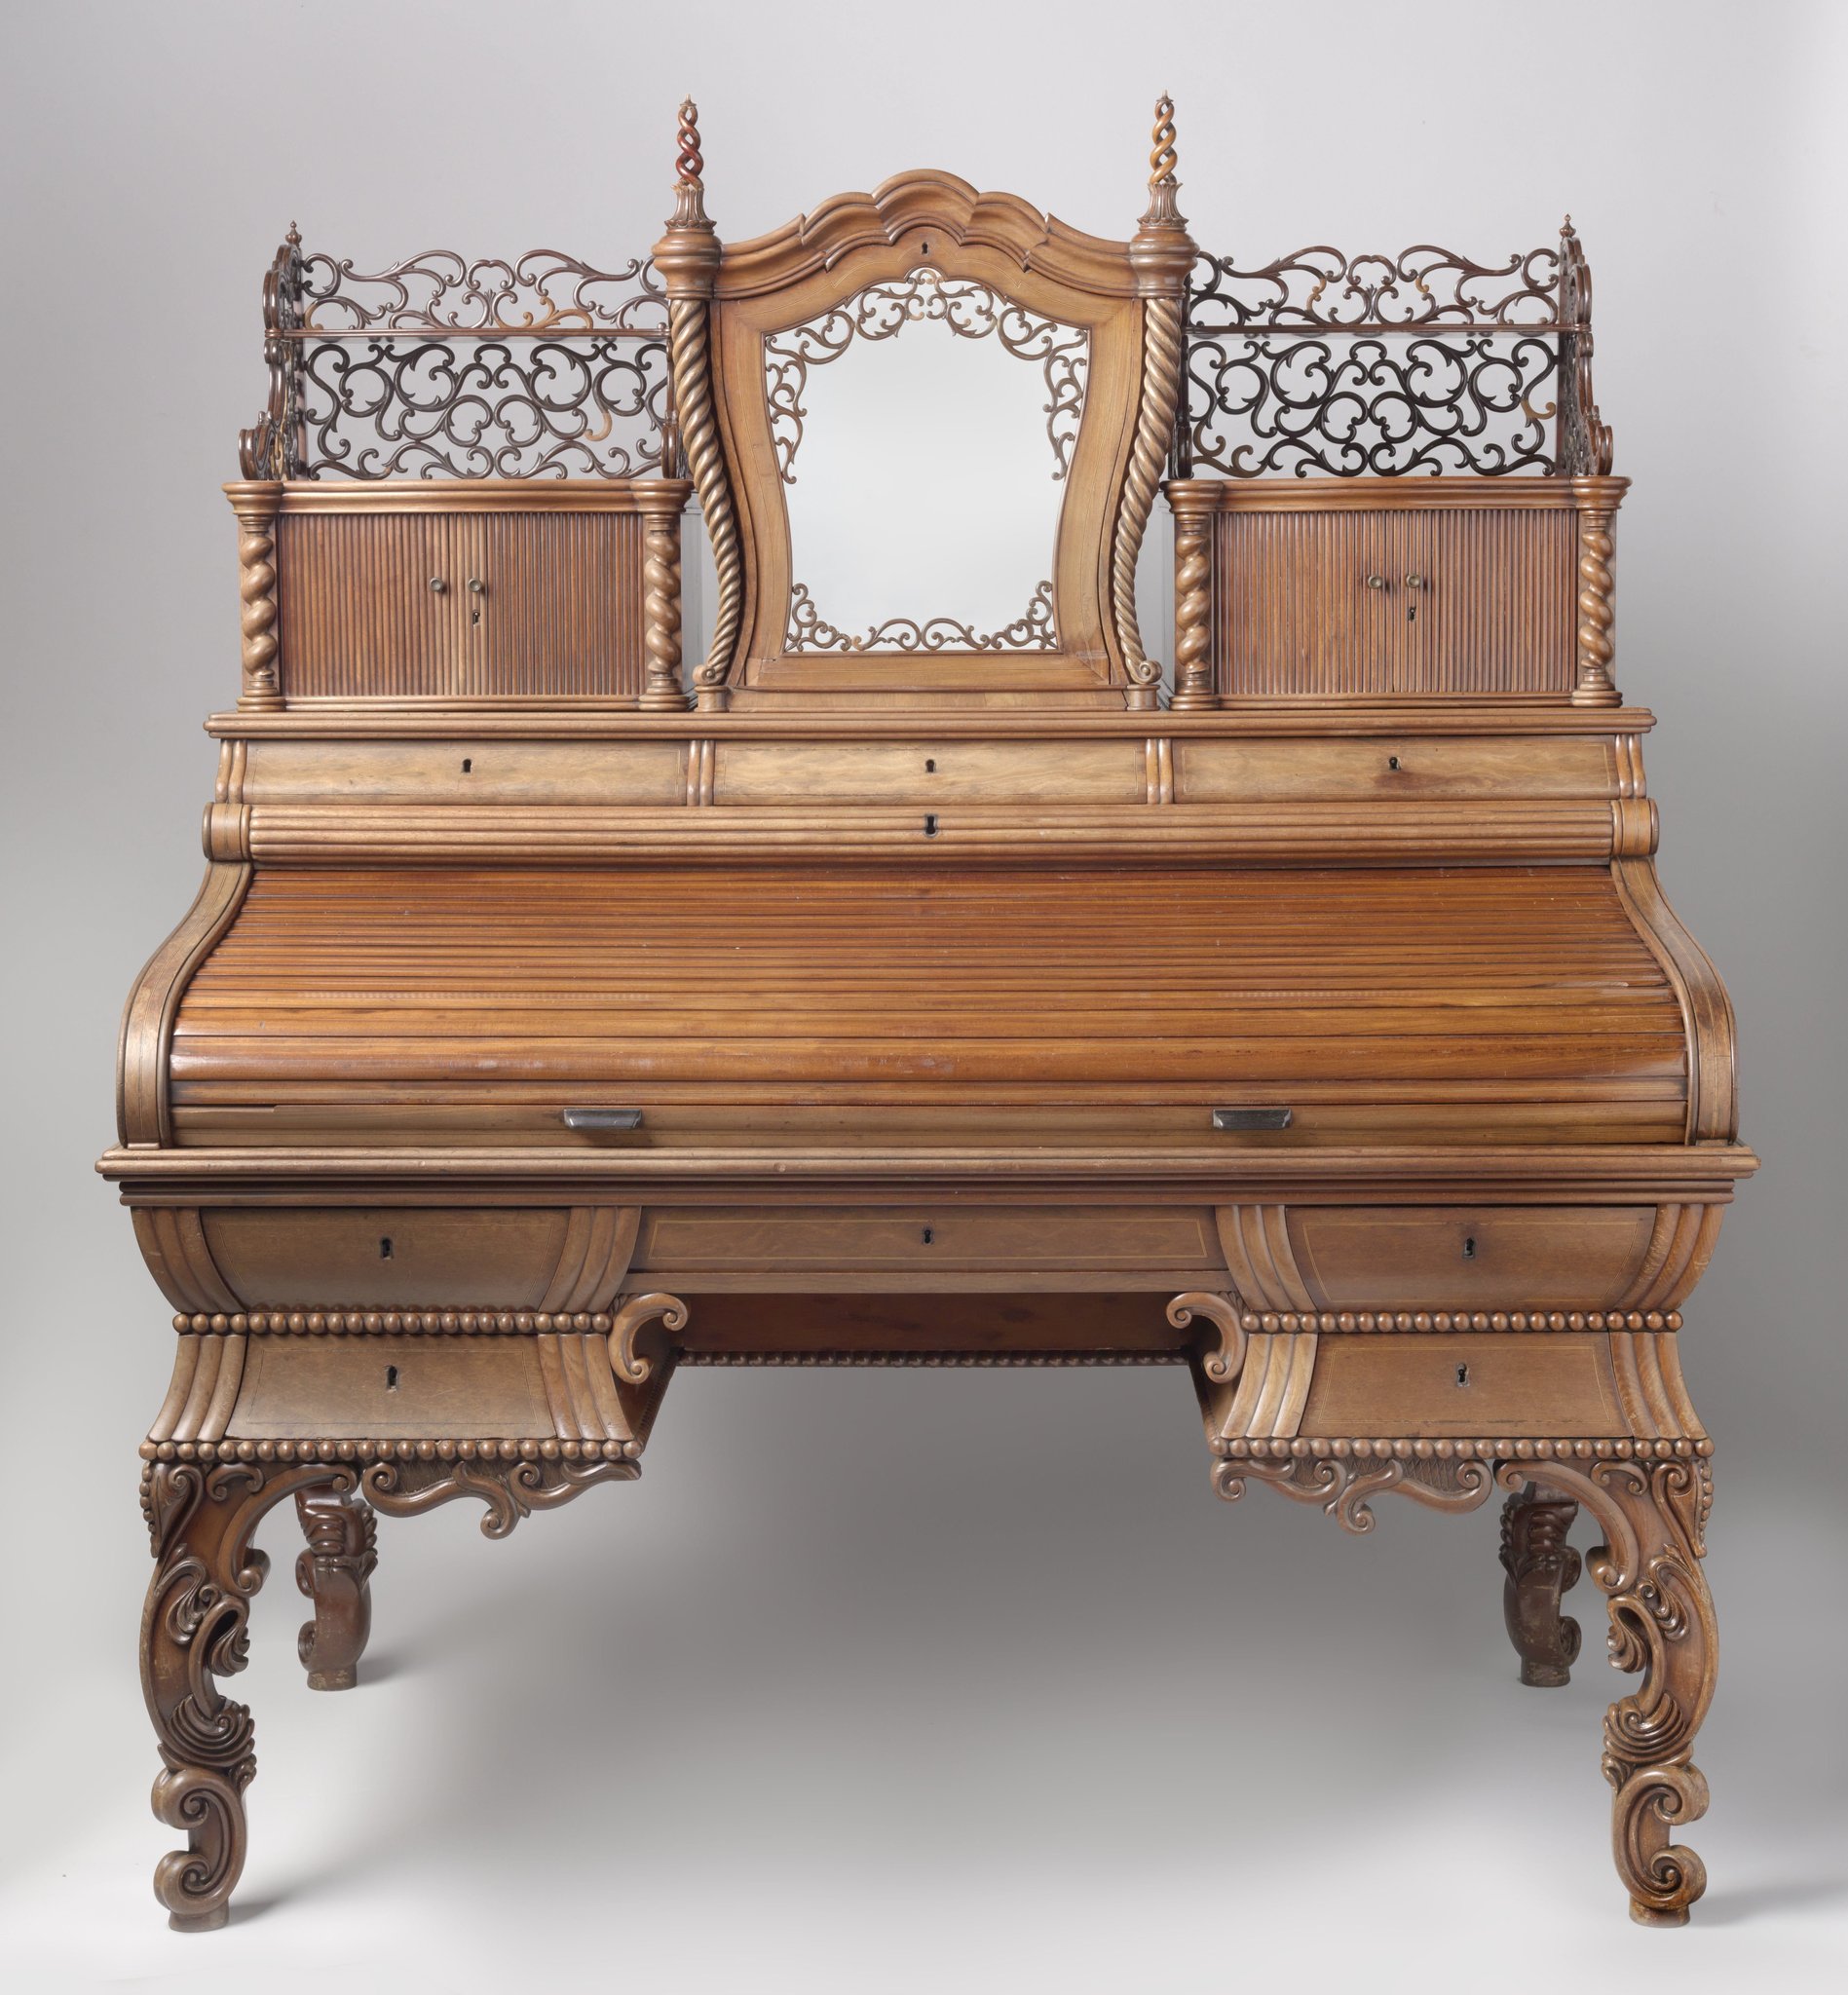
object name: desk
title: Bureau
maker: jan adolf hillebrand jr.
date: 1840-1845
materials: wood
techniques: veneering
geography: leeuwarden